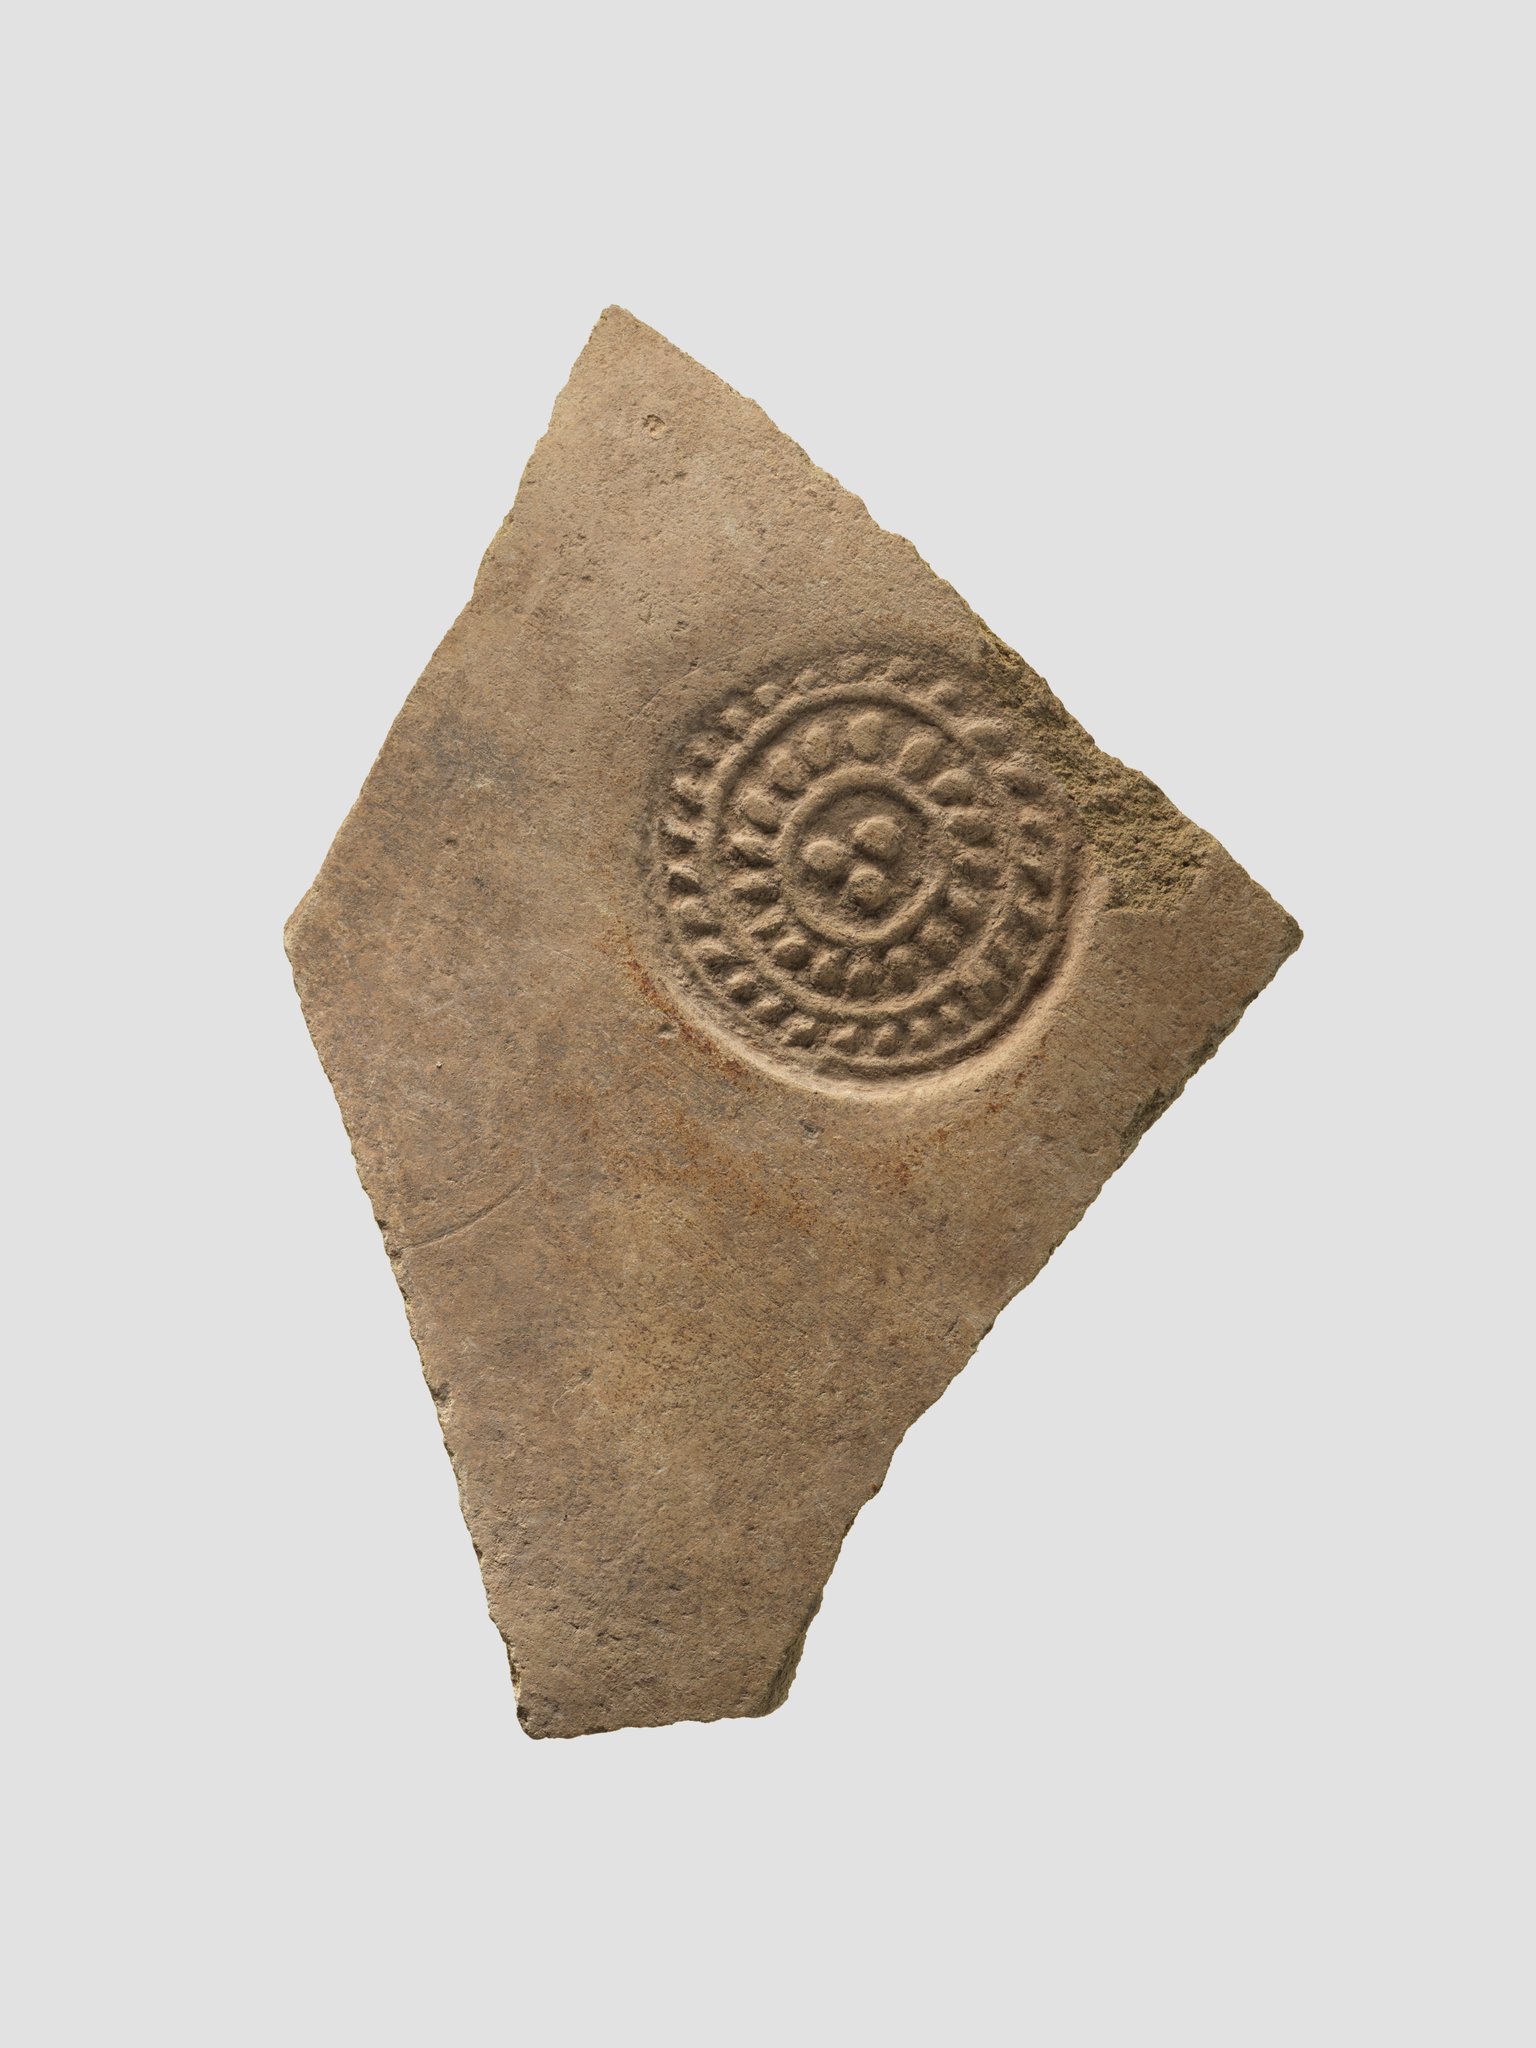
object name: sherd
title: Sherds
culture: sasanian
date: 201-700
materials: ceramic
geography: mesopotamia